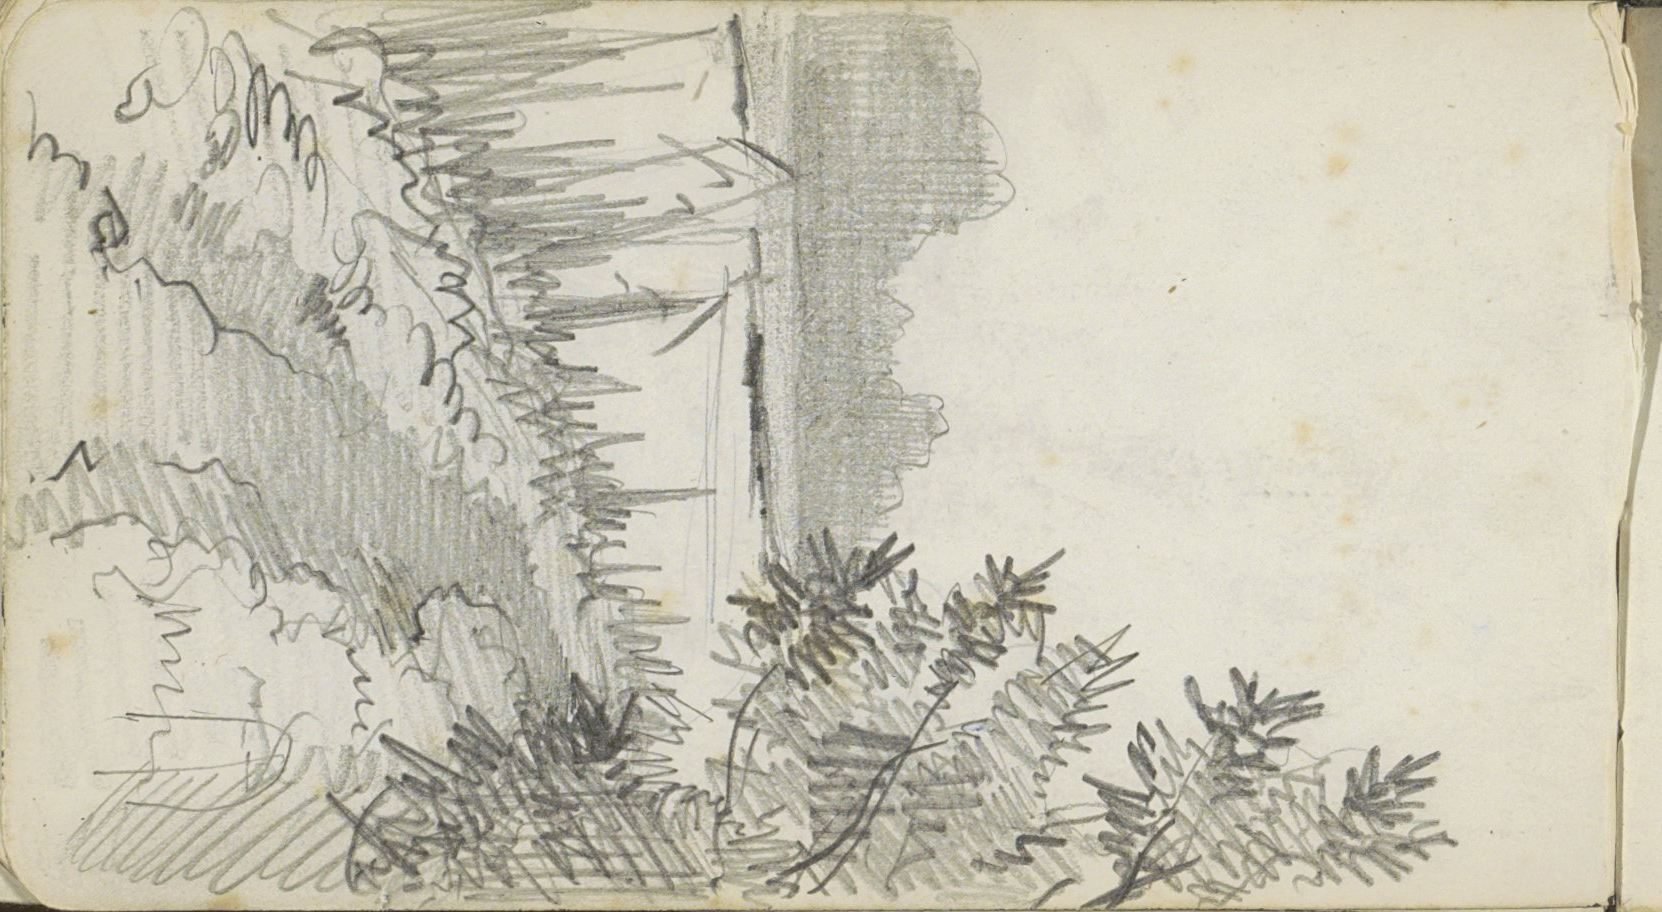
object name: sketchbook leaf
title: Pad langs een waterkant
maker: geo poggenbeek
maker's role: draughtsman, painter, print maker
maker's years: 1853-1903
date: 1809-1876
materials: paper, pencil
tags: fence, wall, paling, landscapes with waters, waterscapes, seascapes (in the temperate zone)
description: Blad 65 verso uit een schetsboek met 69 bladen.